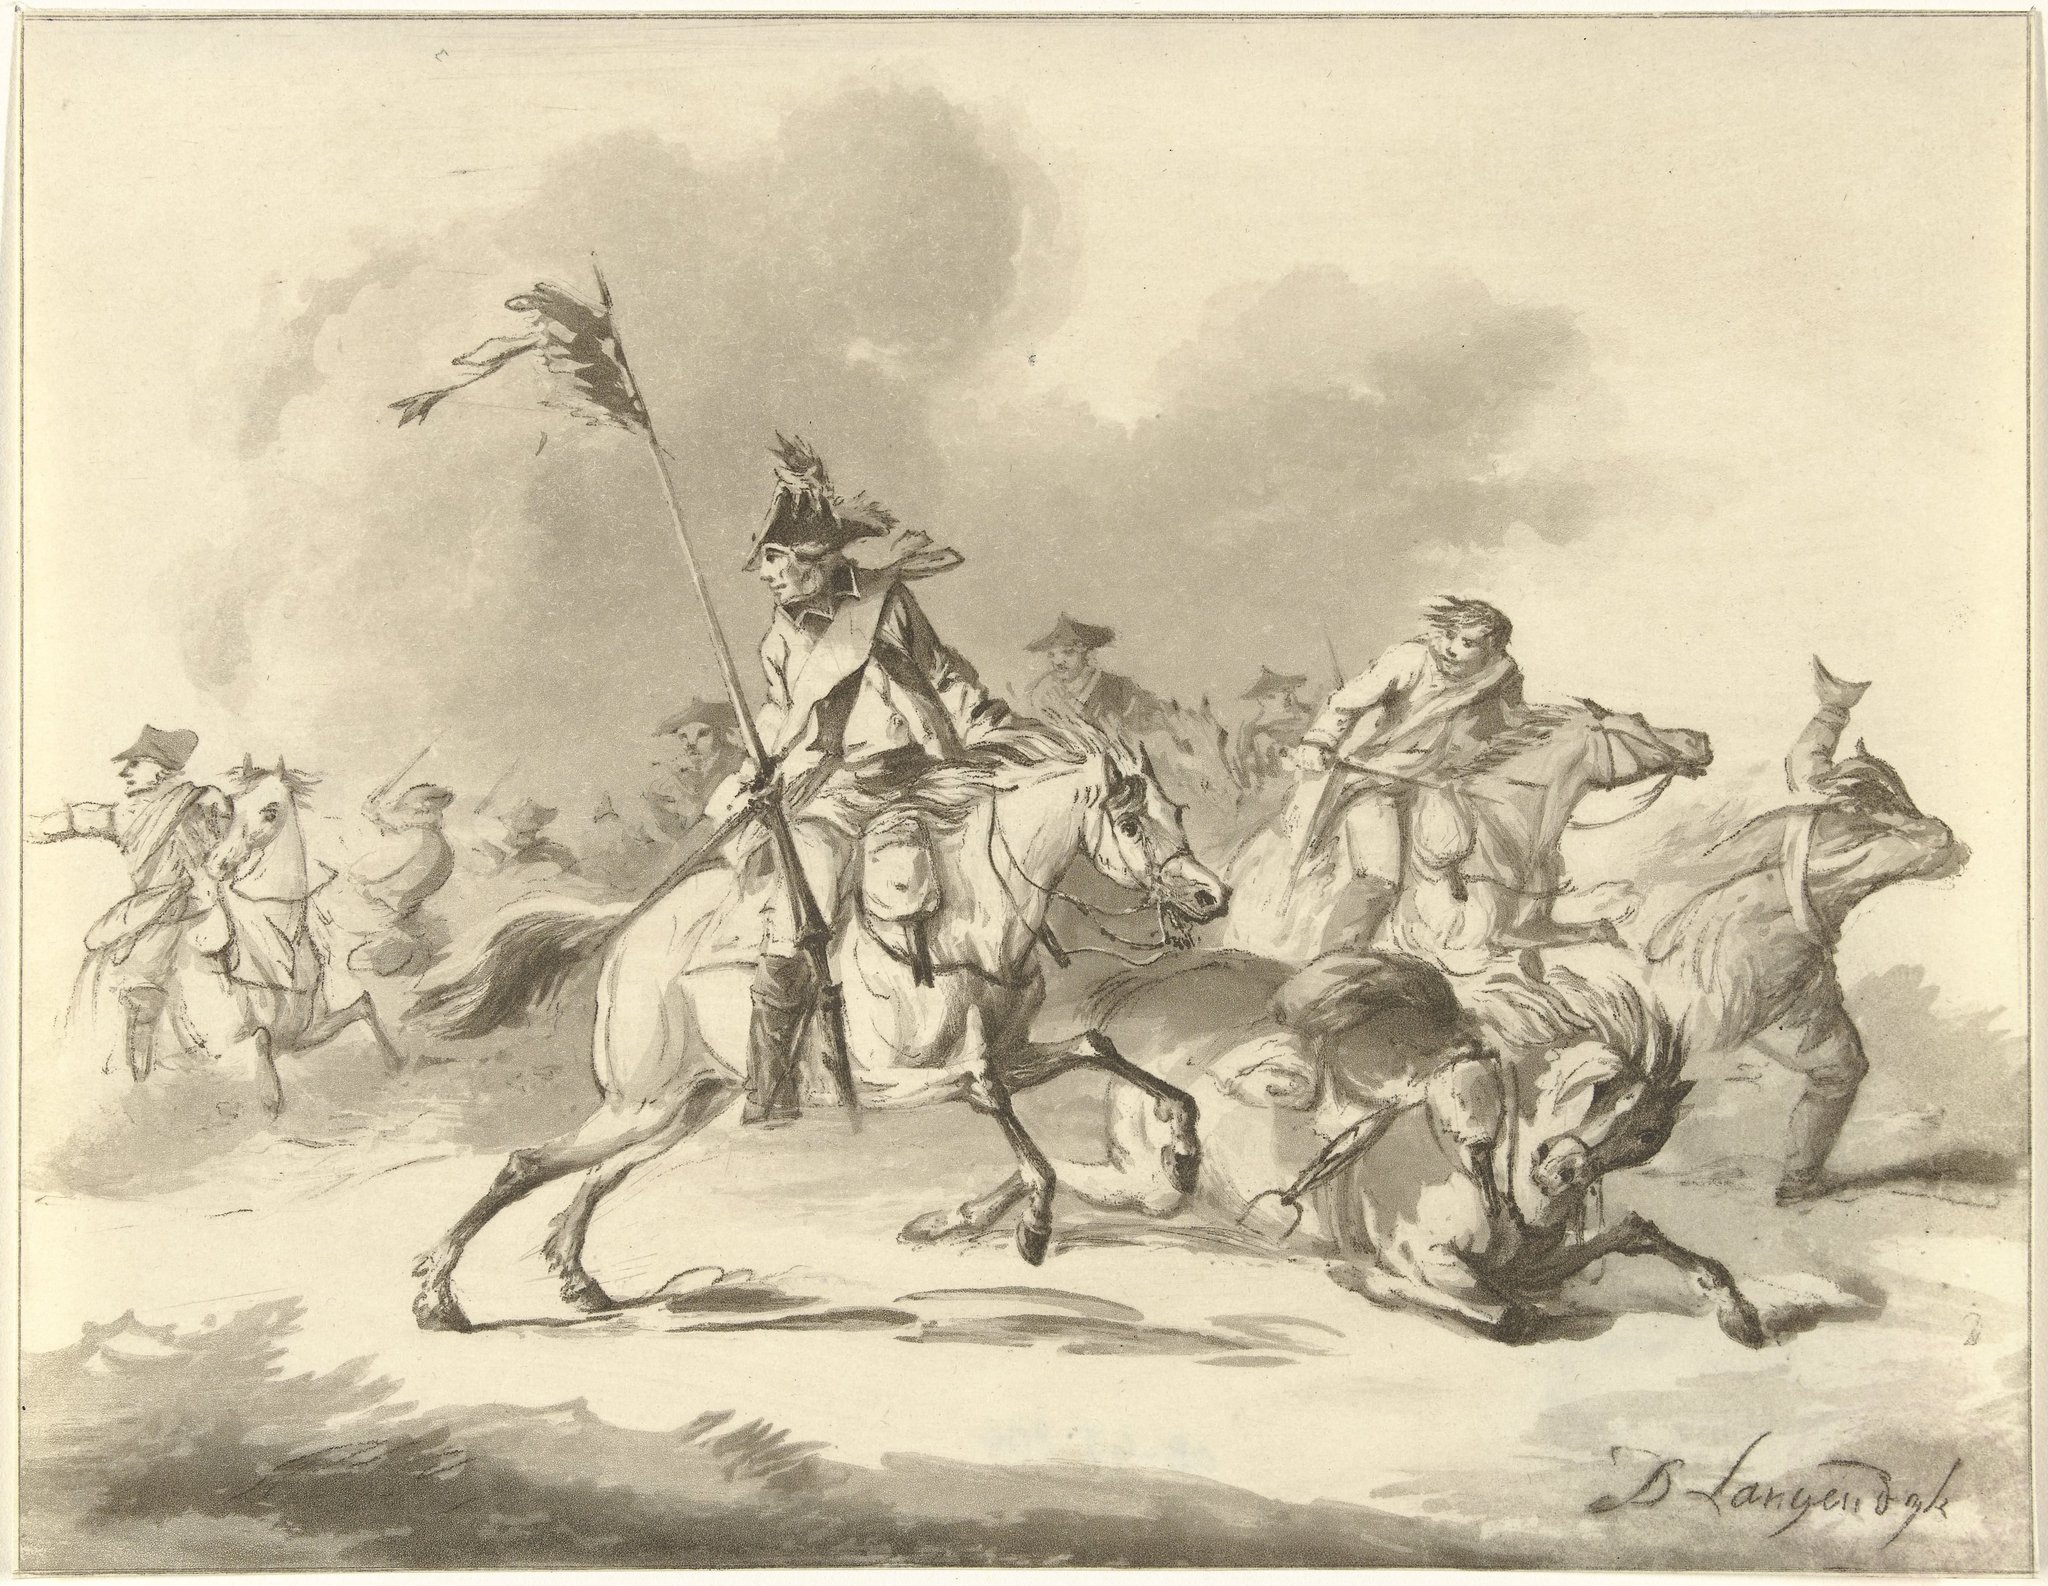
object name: print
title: Vluchtende ruiters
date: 1821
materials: paper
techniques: aquatint, etching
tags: military discipline (+ cavalry, horsemen)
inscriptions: collector's mark: Lugt 12, collector's mark: Lugt 2725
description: Door Christiaan Josi opgenomen in een uitgave met 100 werken naar Hollandse en Vlaamse meesters: Collection d'imitations de dessins d'après les principaux maîtres hollandais et flamands, Londen, C.Josi, 1821. Alle prenten in deze uitgave dragen op het verso het wapen van Cornelis Ploos van Amstel, de initiatiefnemer voor de uitgave.